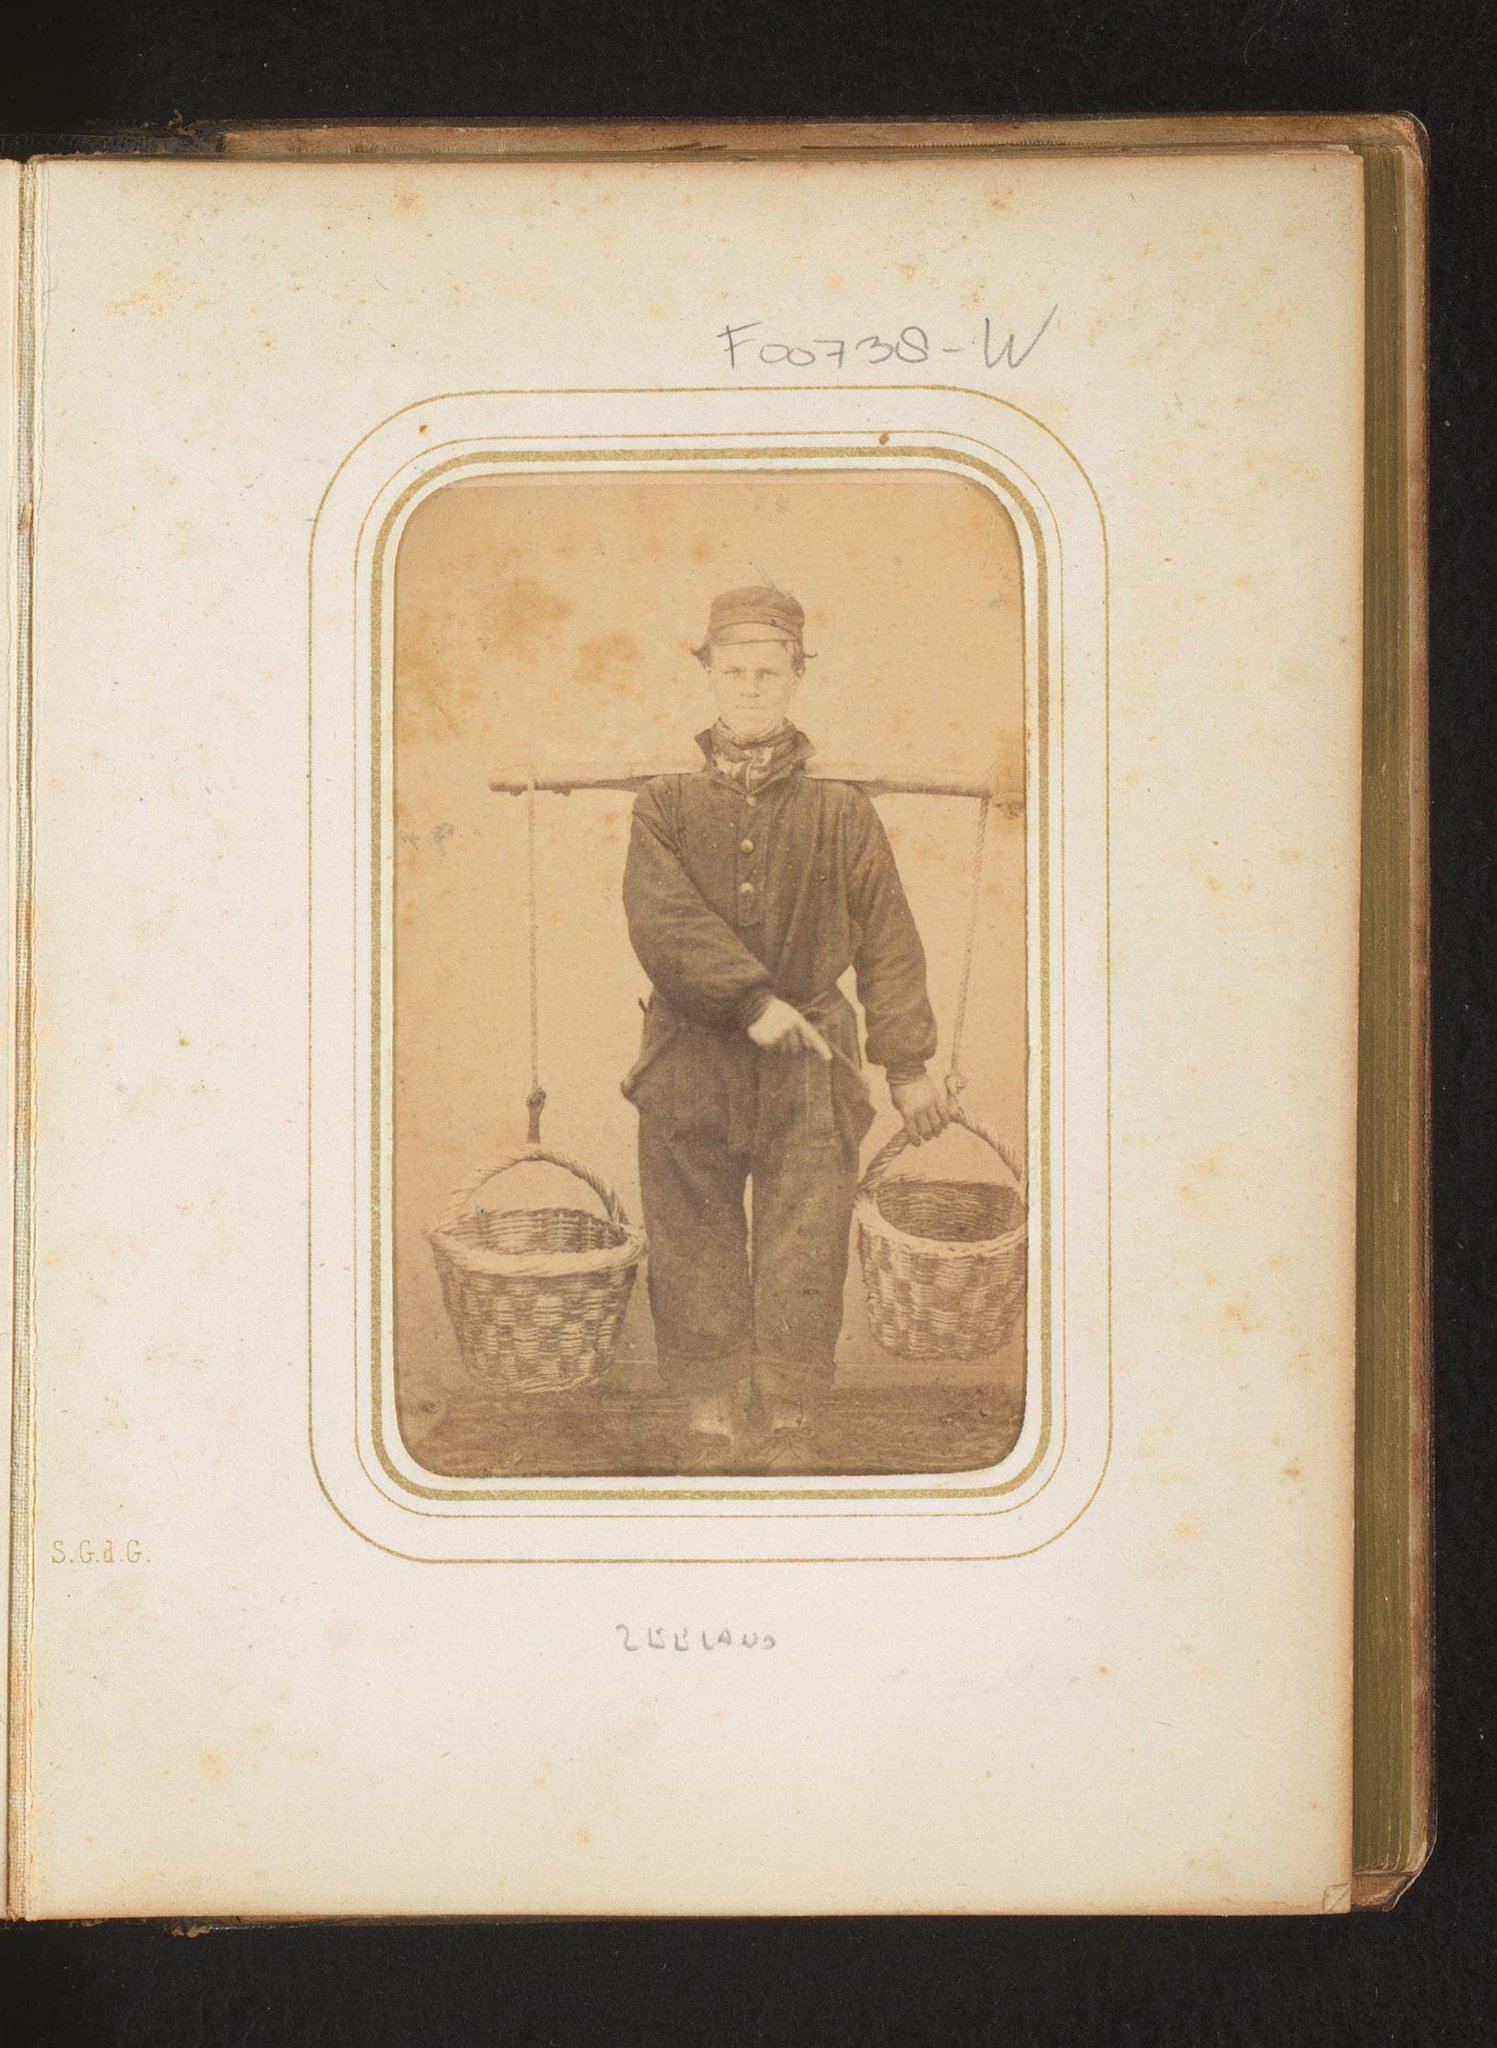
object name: photograph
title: Portret van een man in klederdracht, vermoedelijk van Zeeland, met juk met emmers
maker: hendrik hermanus roelse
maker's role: fotograaf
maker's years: 1831-1872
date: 1852-1872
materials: cardboard, photographic support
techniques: albumen print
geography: middelburg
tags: folk costume, regional costume (+ men's clothes), historical persons, carrying something with yoke, netherlands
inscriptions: inscription: ‘Breveté S.G.D.G.’, inscription: ‘H. H. ROELSE/ PHOTOGRAPHE/ MIDDELBURG.’, annotation: ‘Zeeland’